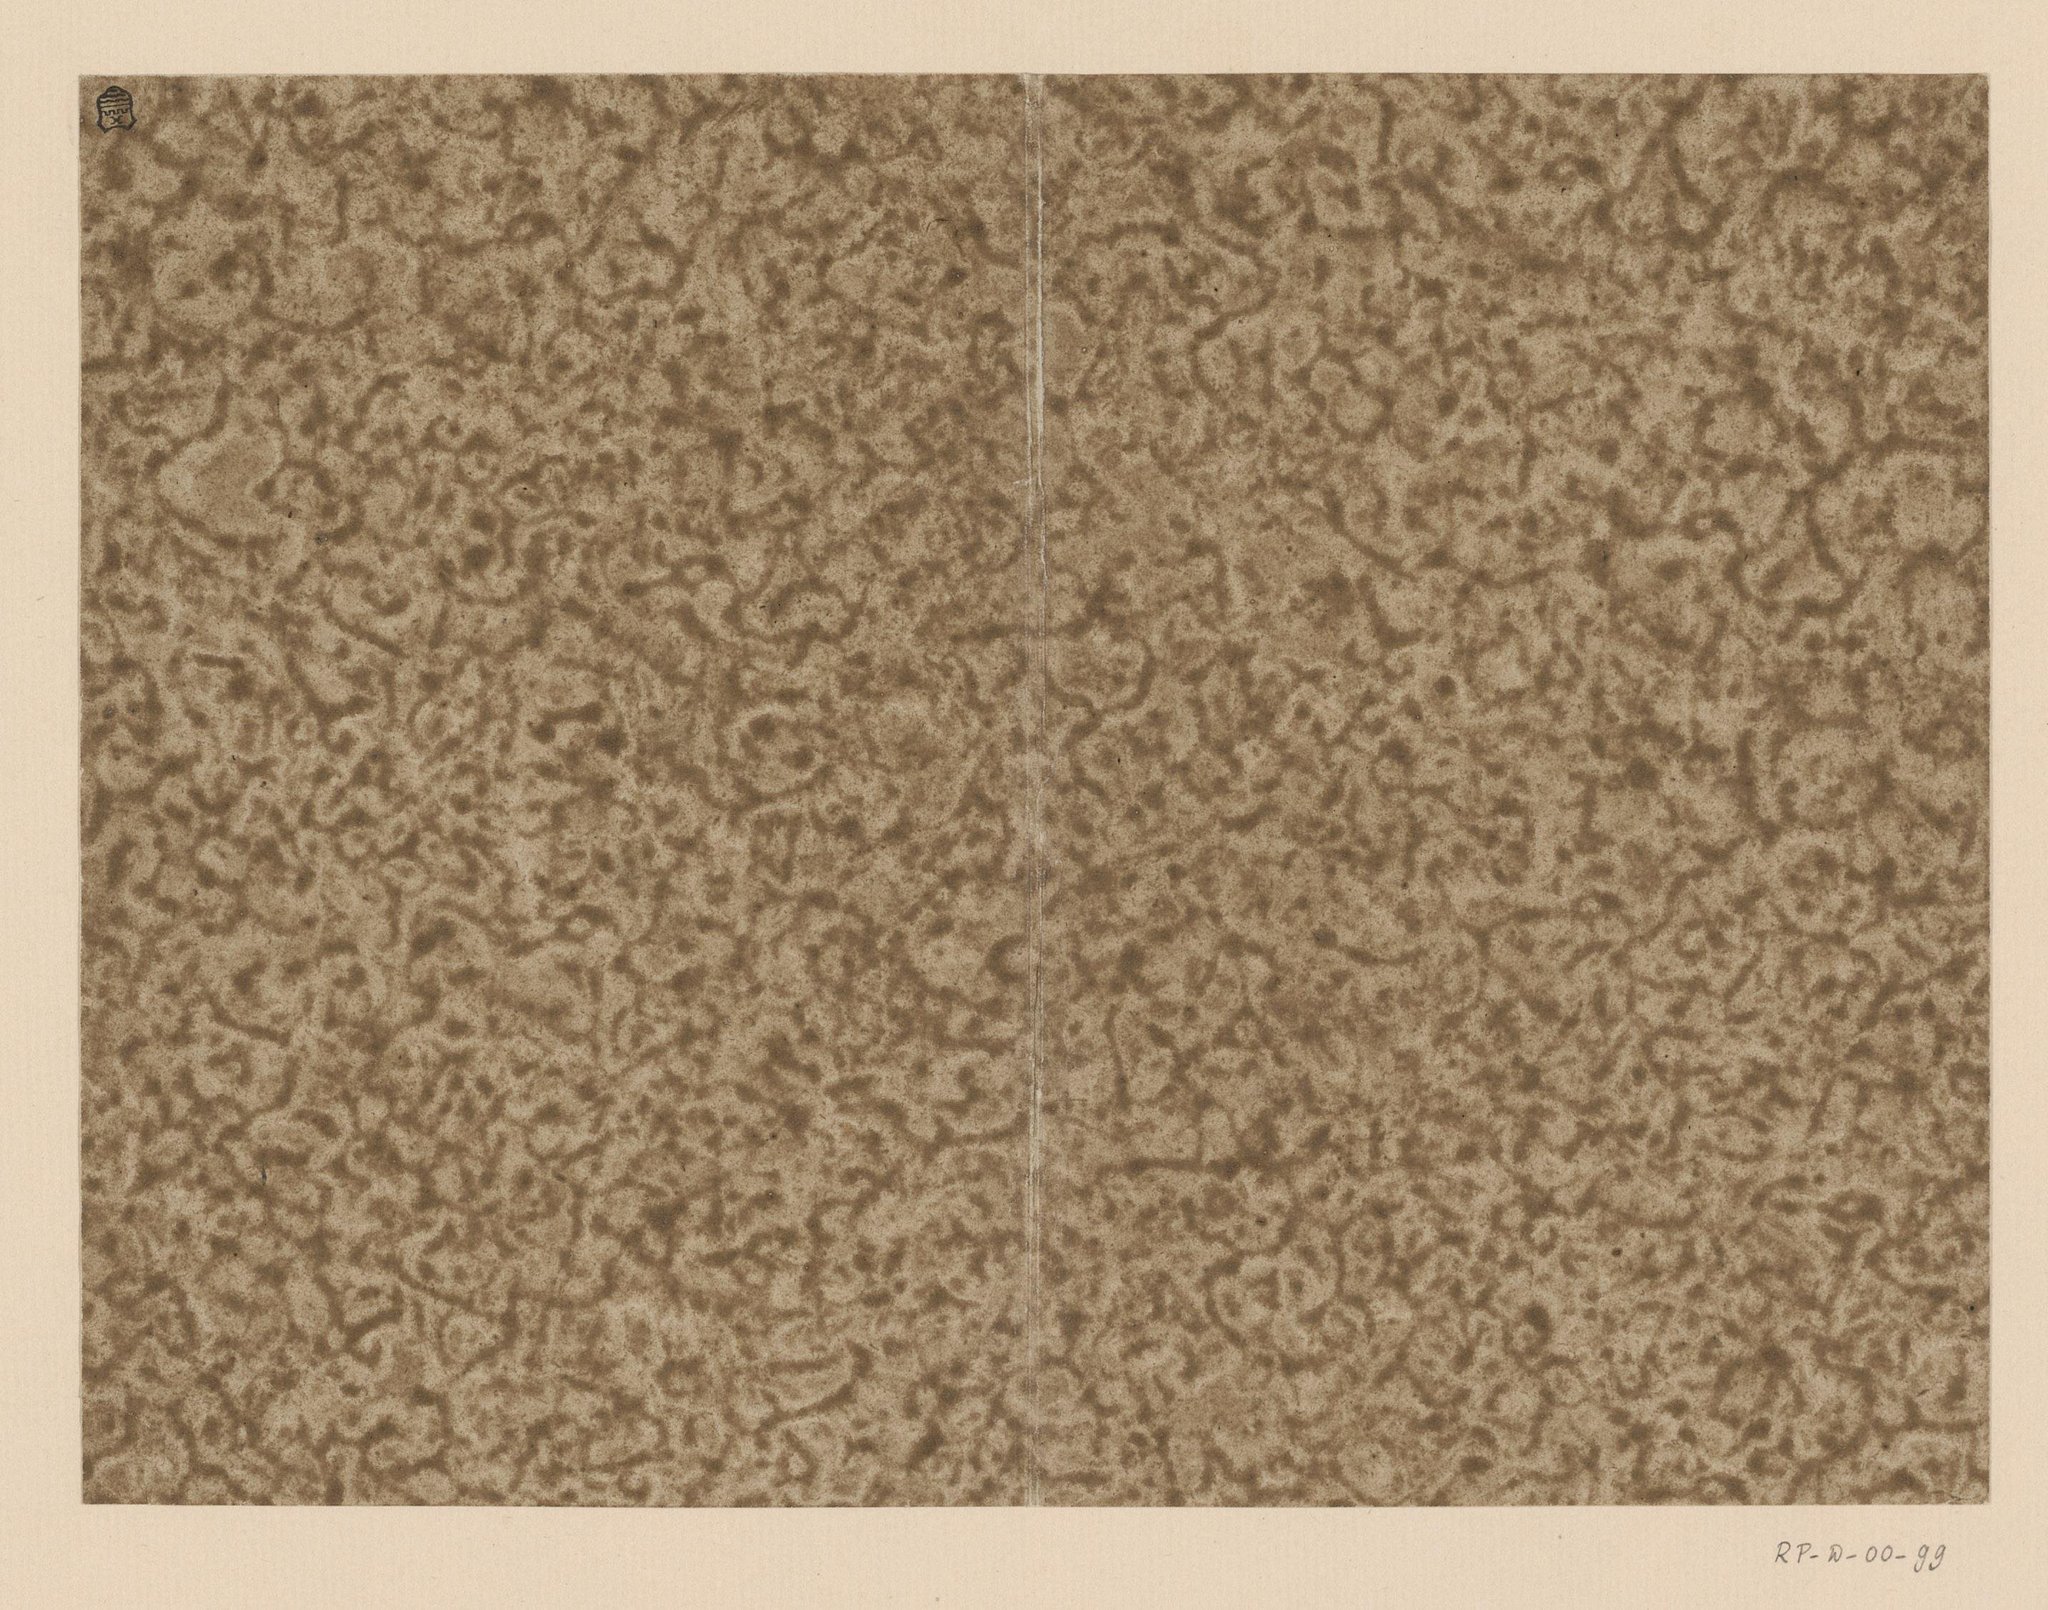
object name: paste paper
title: Geaderd stijfselverfpapier in bruin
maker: Anonymous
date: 1700-1900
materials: paper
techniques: starch dyeing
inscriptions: collector's mark: Lugt 2760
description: Geaderd stijfselverfpapier in bruin. Gebruikt als omslag.